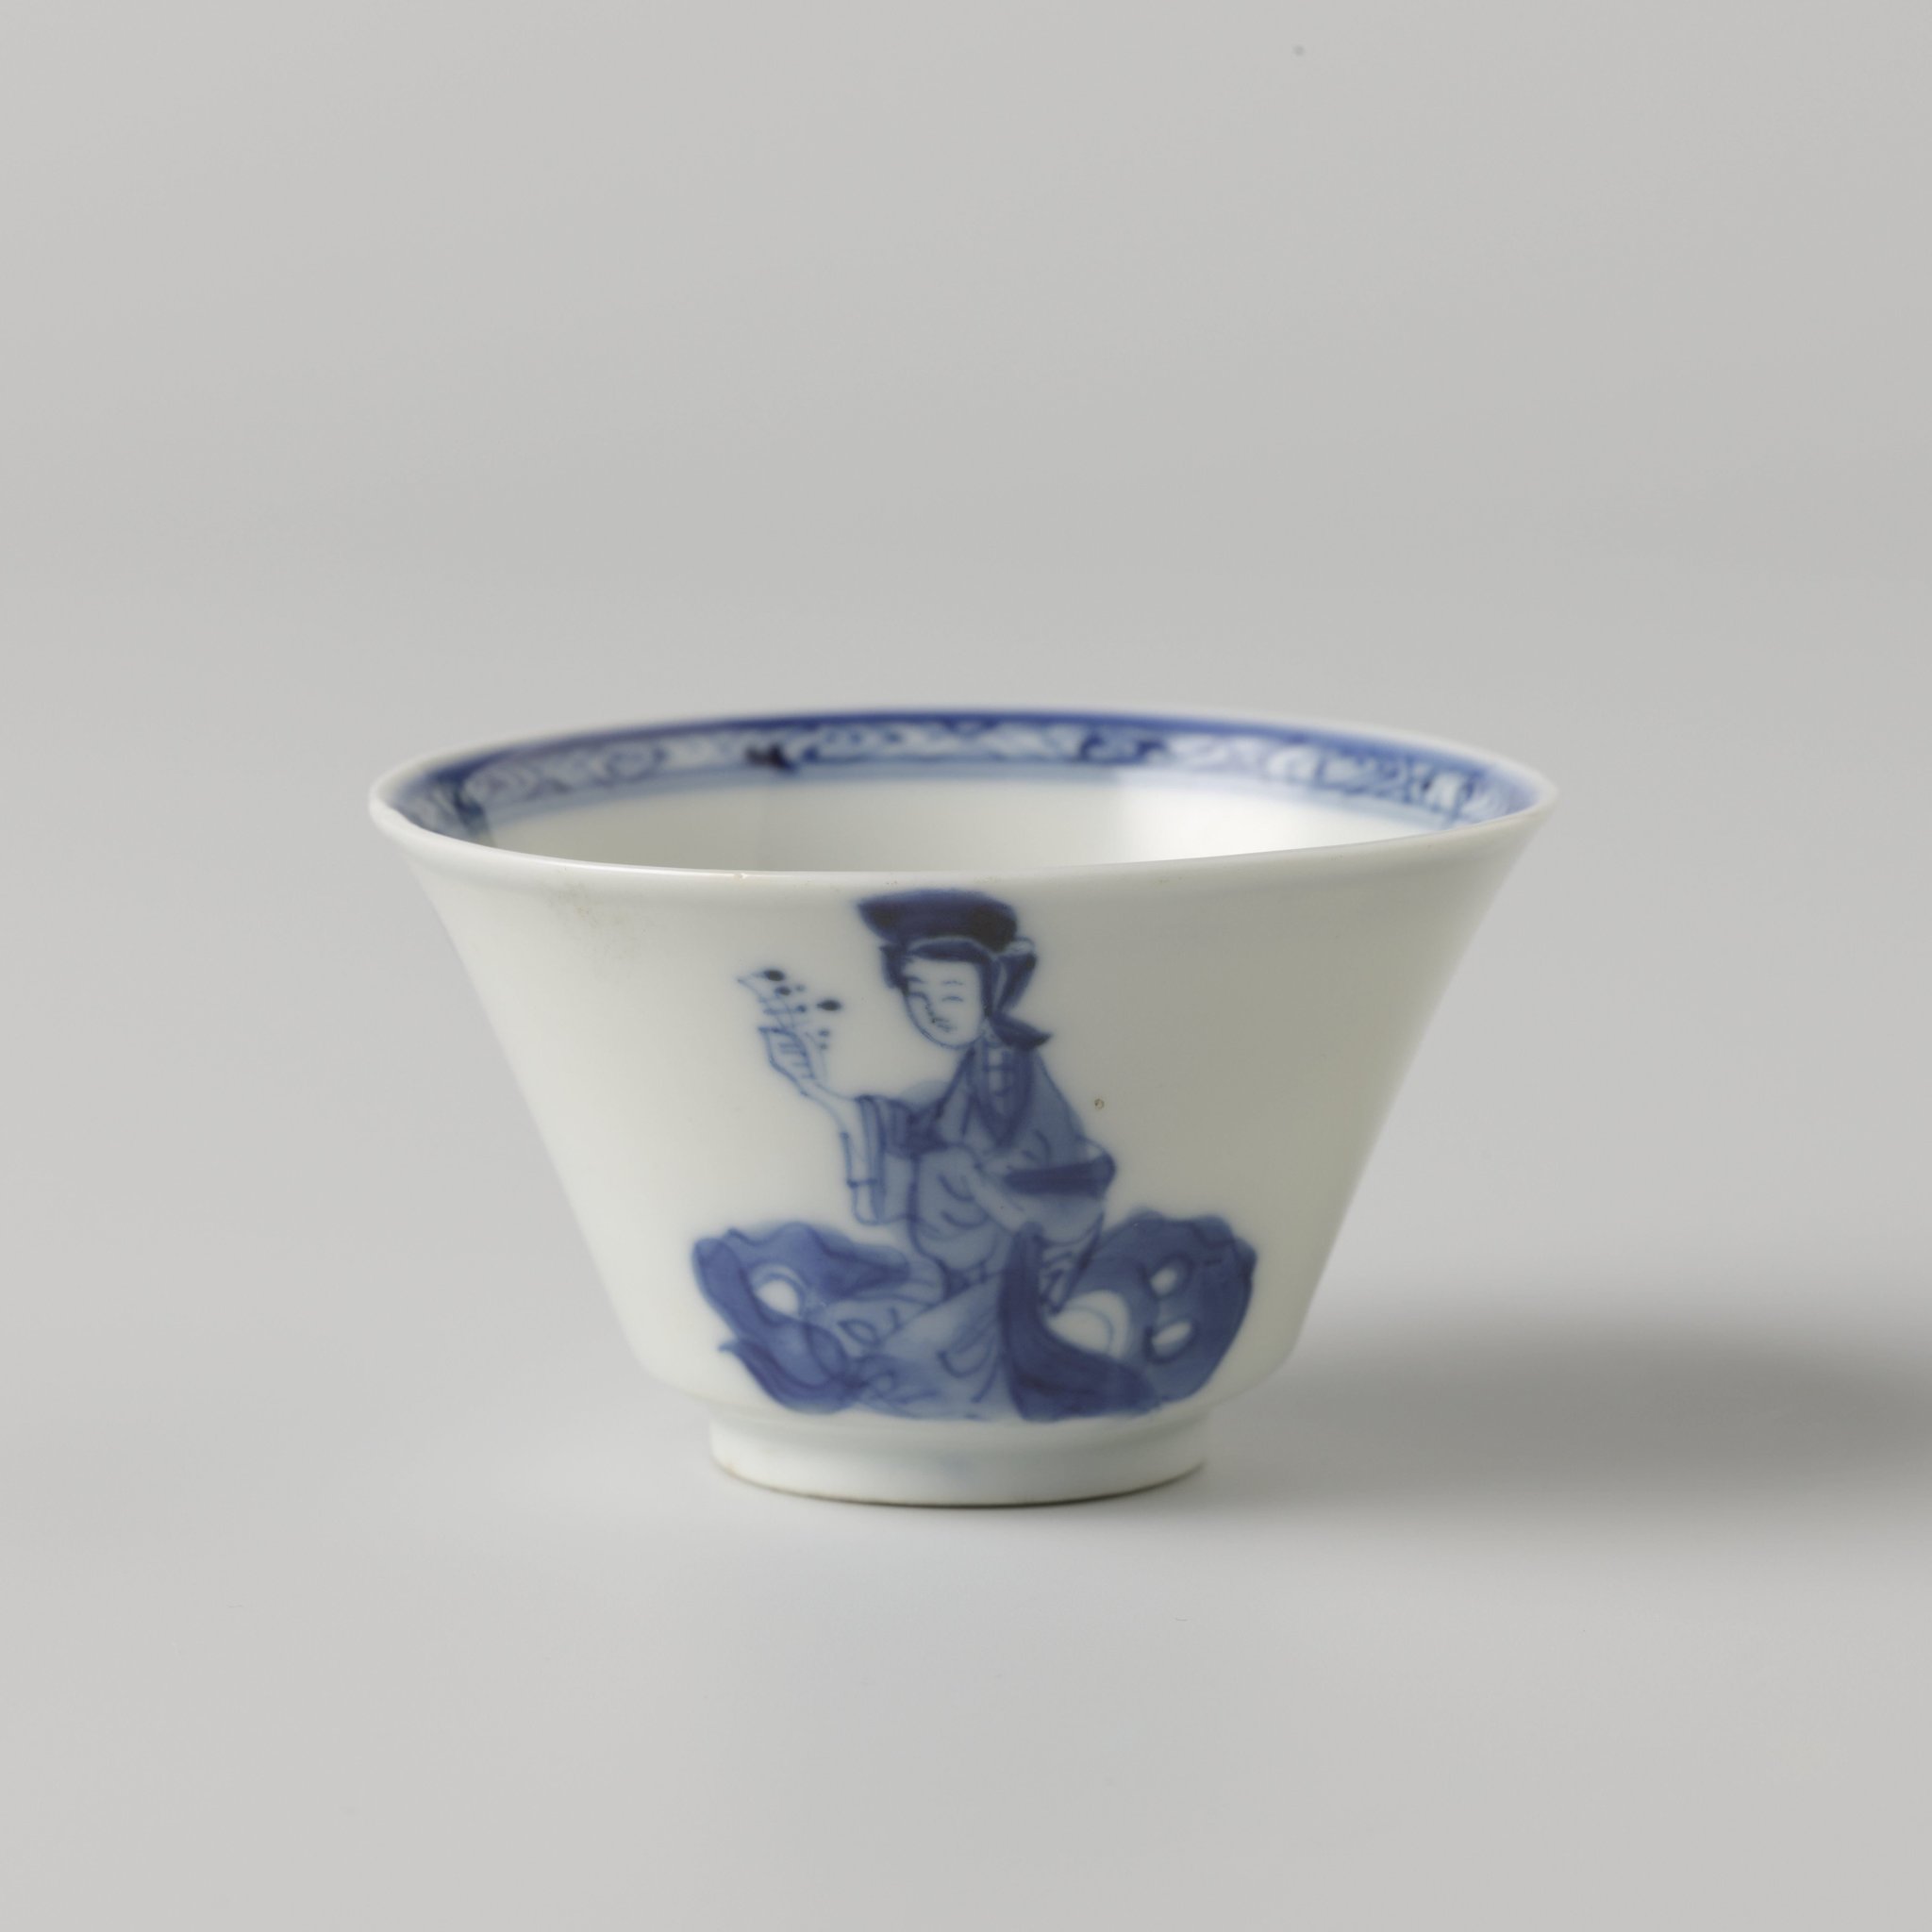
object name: cup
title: Cup with flaring sides with a woman and boy near a rock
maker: Anonymous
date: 1680-1720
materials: cobalt, glaze, paint, porcelain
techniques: firing, turning, vitrification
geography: china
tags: the hague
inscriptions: mark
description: Kop van porselein met spreidende wand, beschilderd in onderglazuur blauw. Op de buitenwand een vrouw (lange lijs) zittend op een rots met een takje in haar hand; naast haar een jongen (zotje) en een grotere rots met planten. Op de bodem een rivierlandschap met bergen. De binnenrand met arceerwerk. Gemerkt op de onderzijde met het vier-karaktermerk van keizer Chenghua in een dubbele cirkel. Blauw-wit.